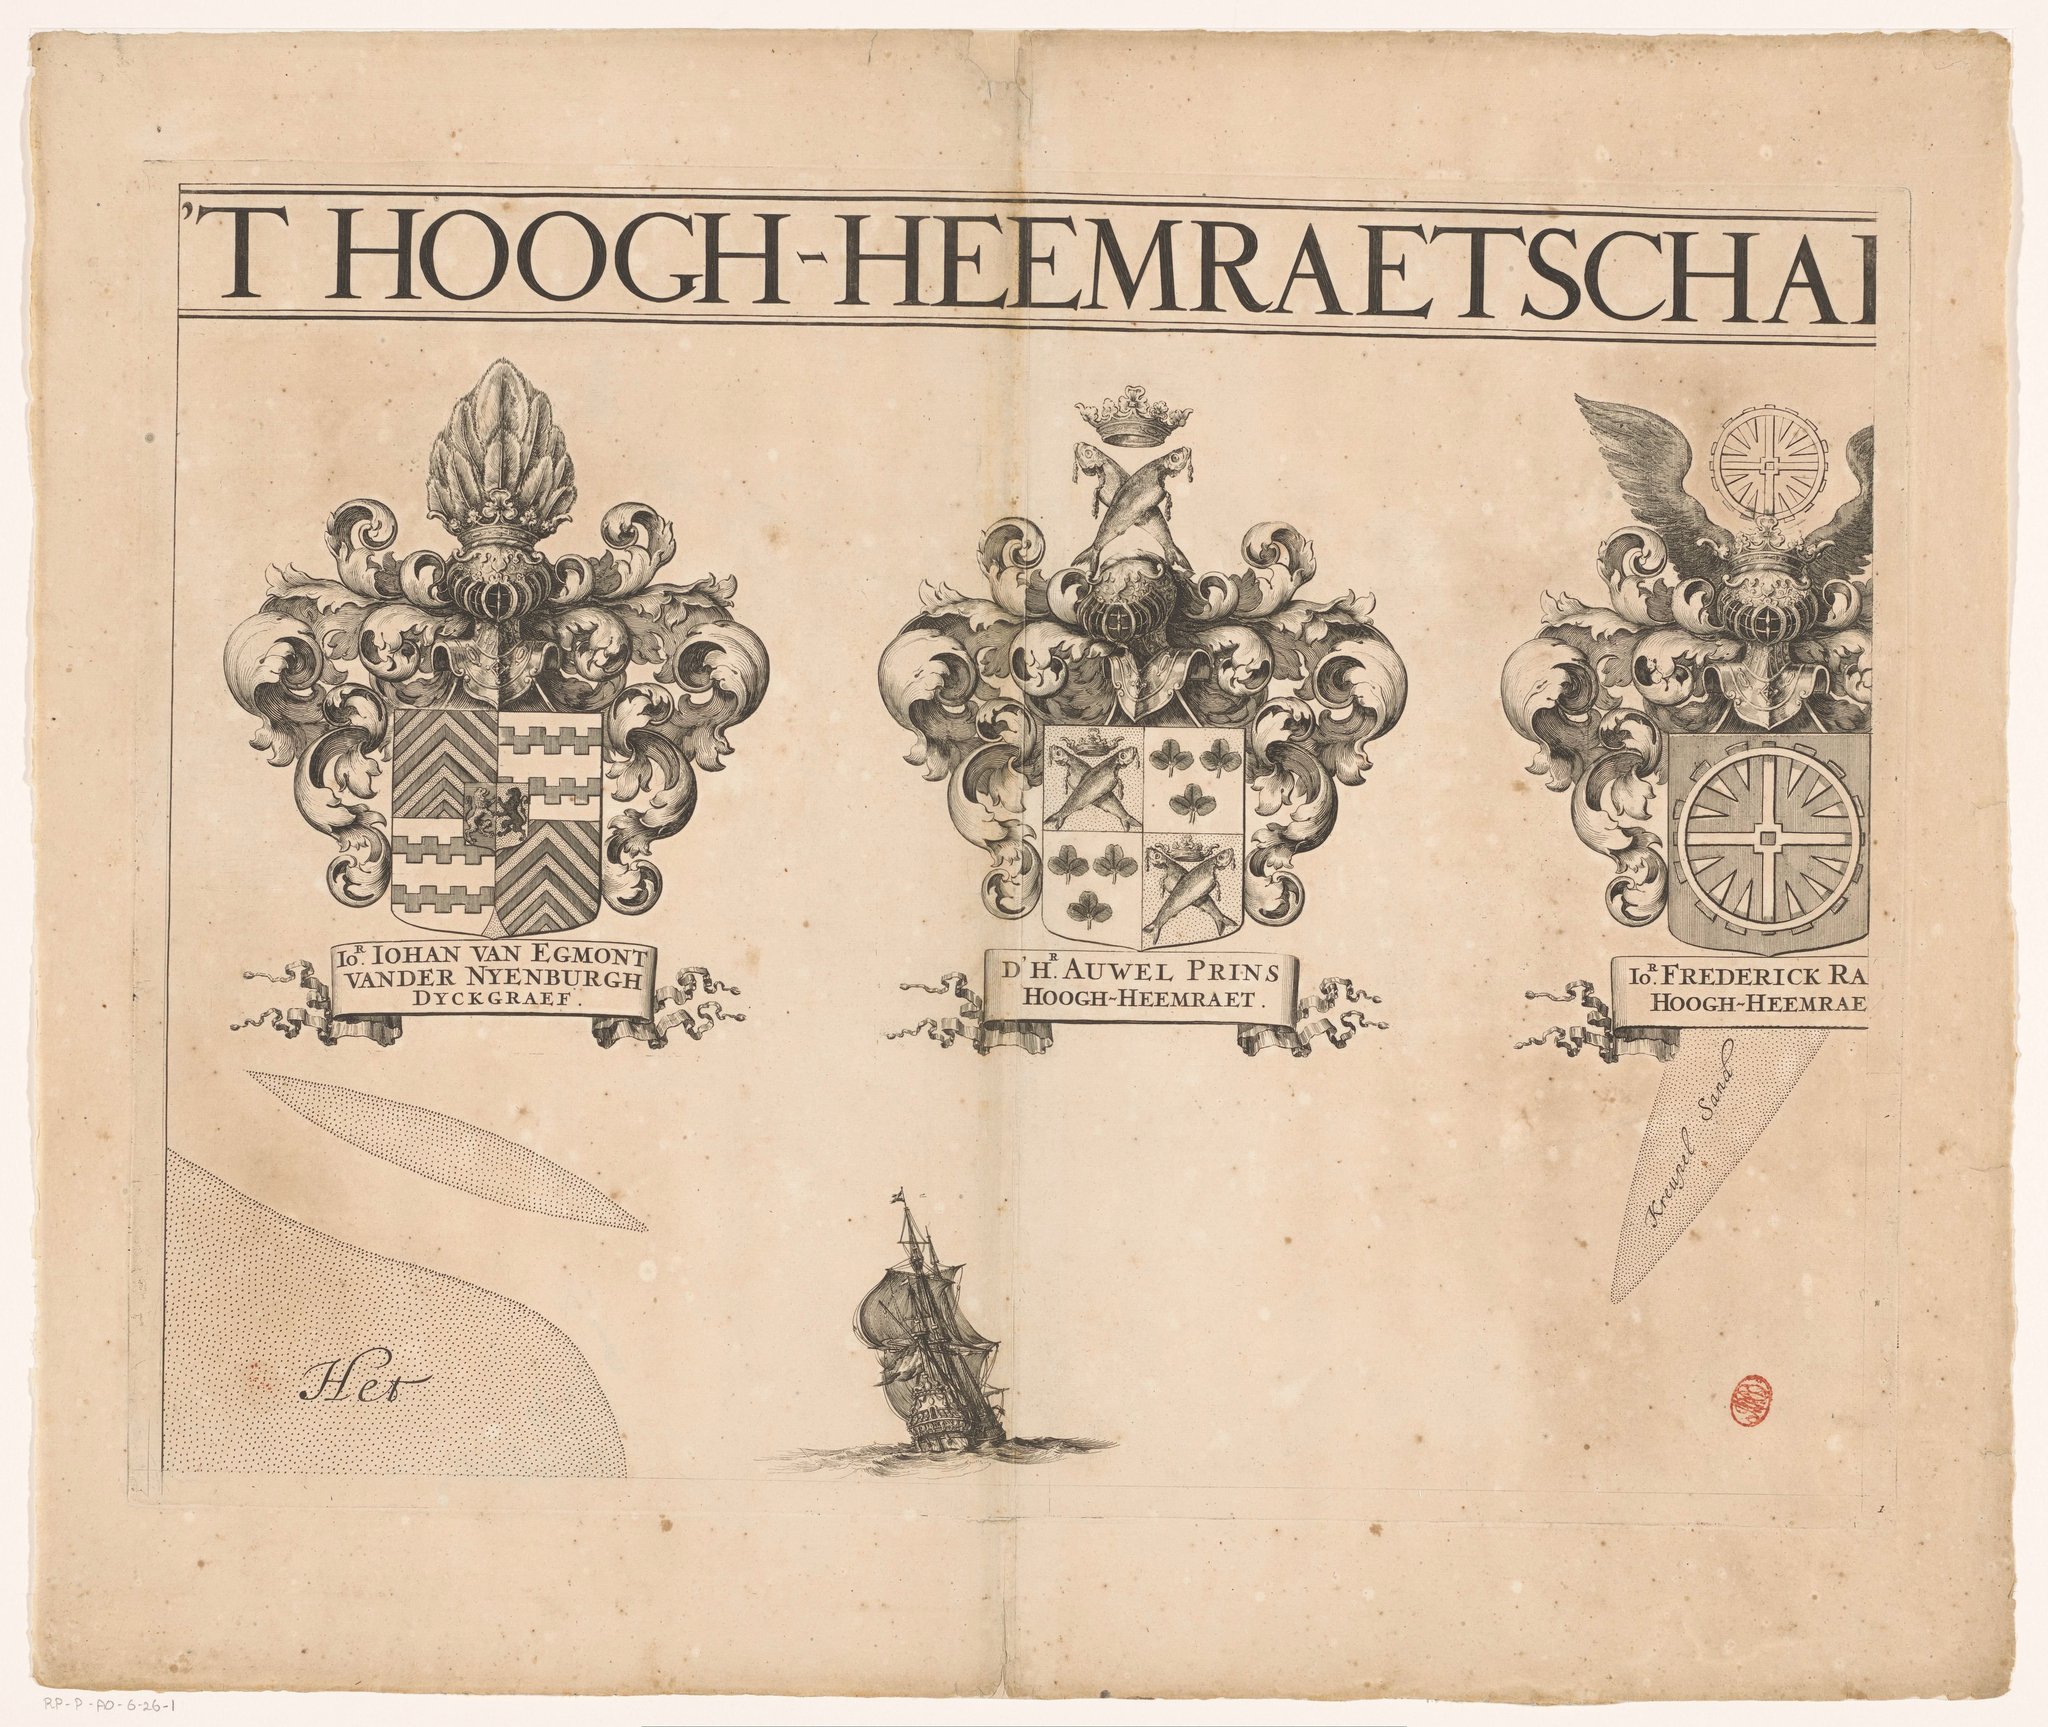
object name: map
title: 't Hoogh-heemraetschap vande Uytwaterende Sluysen in Kennemerlandt ende West-Frieslandt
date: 1680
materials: paper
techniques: engraving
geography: amsterdam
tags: coat of arms (as symbol of the state, etc.), maps of separate countries or regions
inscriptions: collector's mark: Lugt 195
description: Eerste deel van een kaart van Kennemerland en West-Friesland. Rechtsonder genummerd: 1.